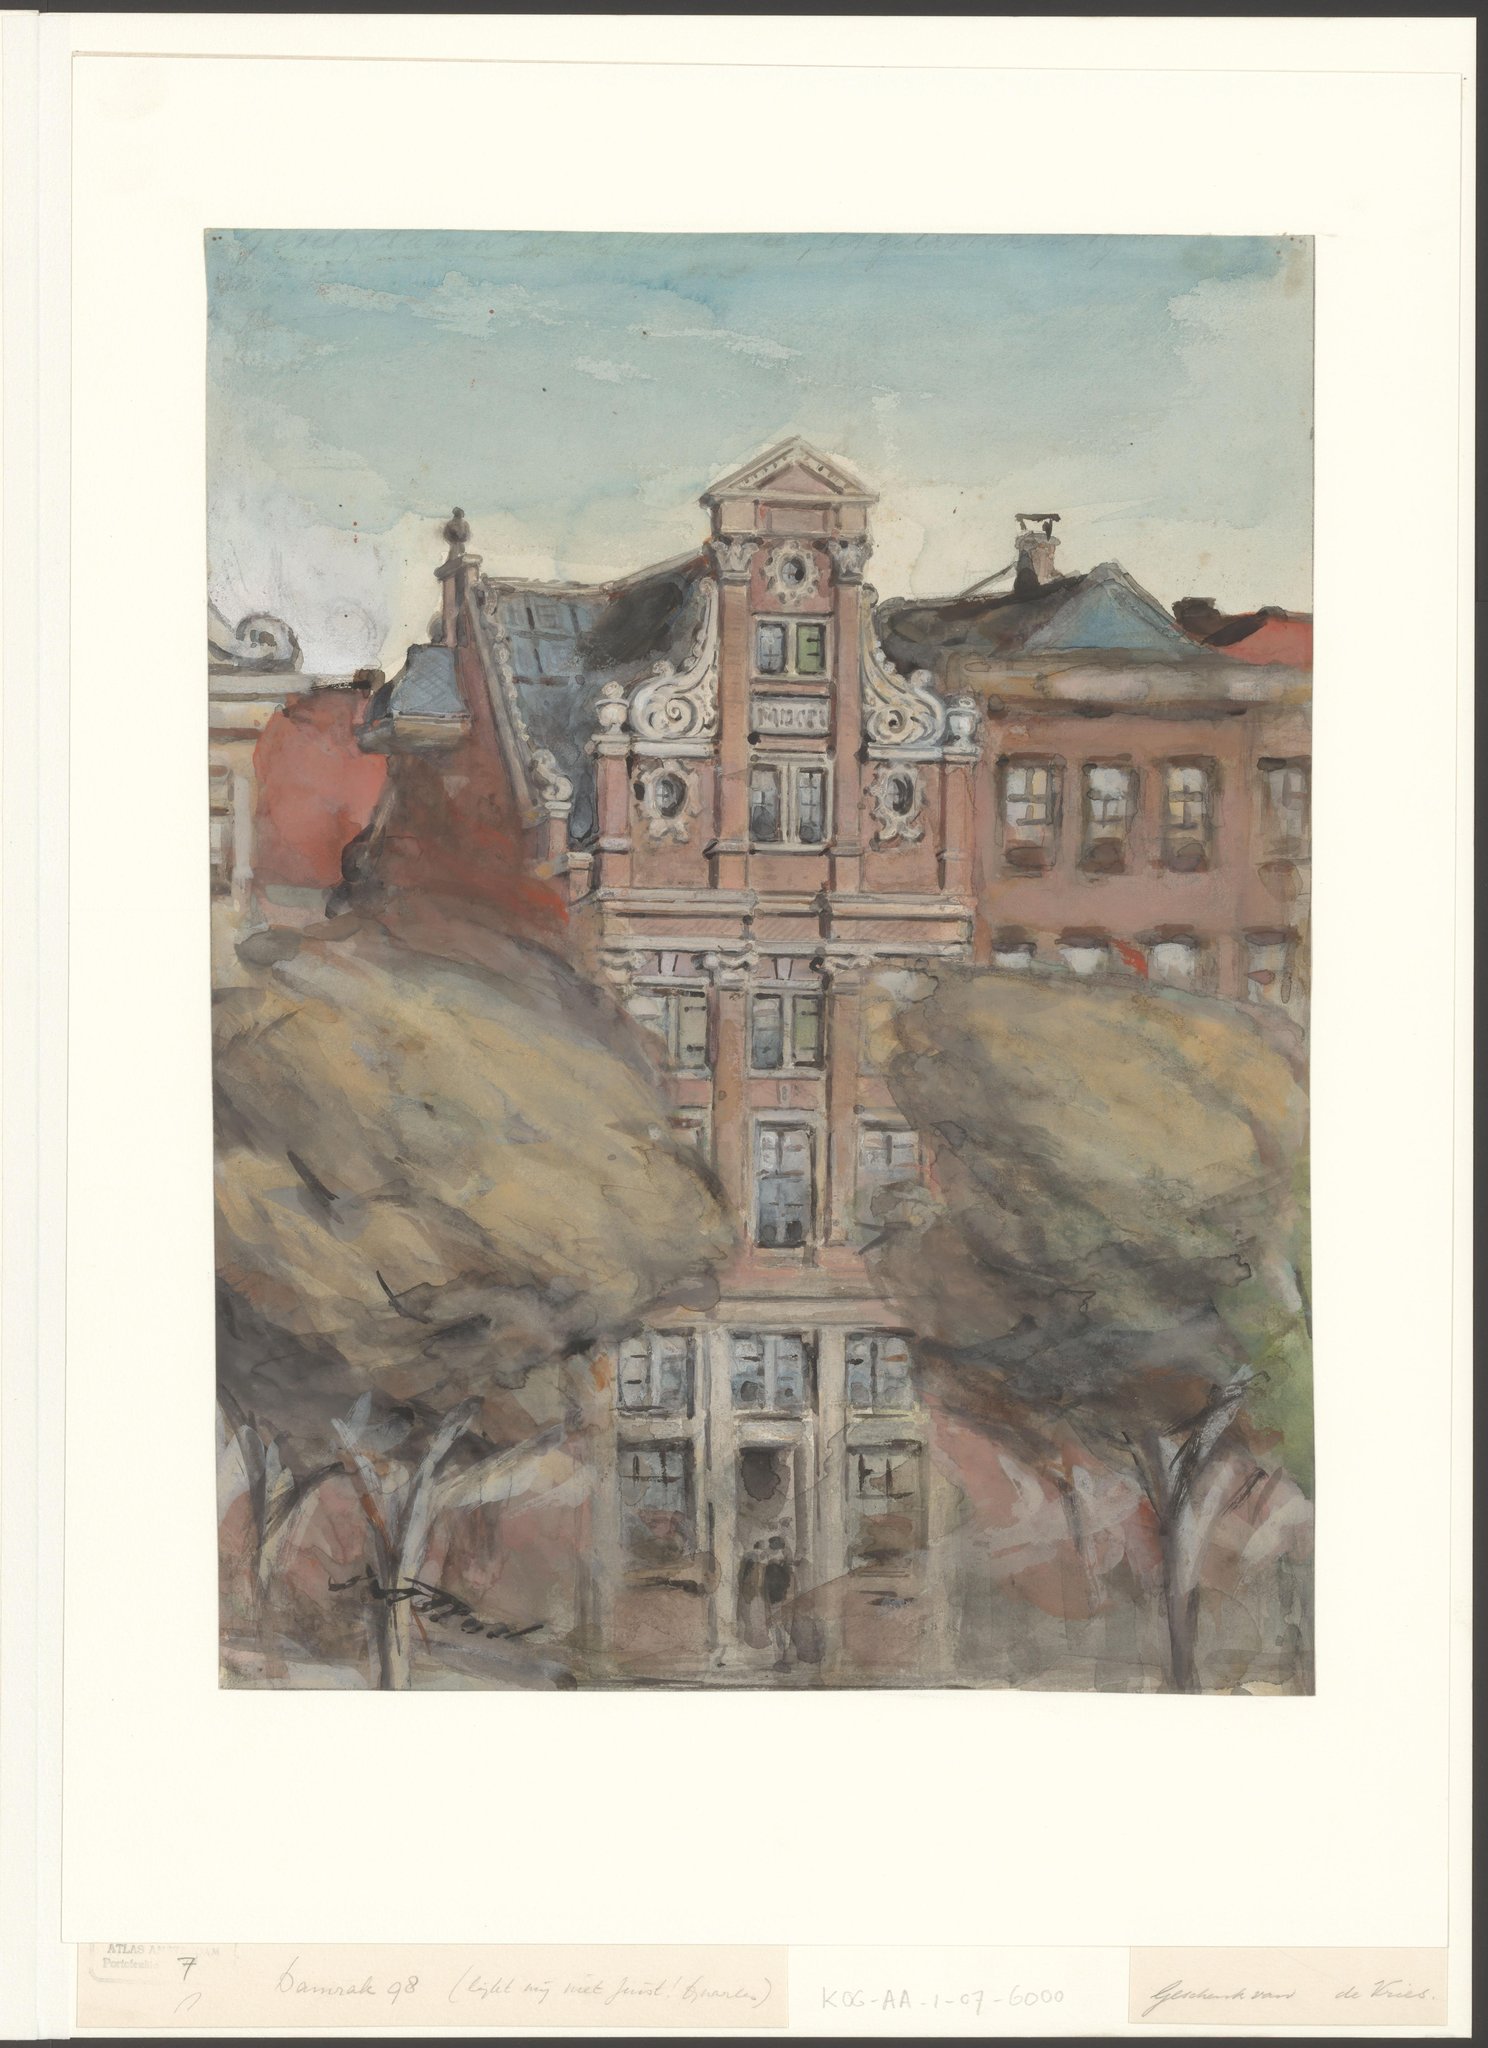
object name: drawing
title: Gezicht op een gevel, mogelijk Damrak 98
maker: johan adolph rust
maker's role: draughtsman, painter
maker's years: 1828-1915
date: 1838-1911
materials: paint, gouache, paper, pencil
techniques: brush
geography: amsterdam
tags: city-view in general; 'veduta', façade (of house or building)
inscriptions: inscription: ‘Port. 7 / A’, inscription: ‘Gevel damrak hoek (...) afgebroken in 1911 / [...] (?)’, inscription: ‘Damrak 98 (lijkt (...) van de Vries.’, collector's mark: ‘7’ Lugt 1641b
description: Onderwerpsrubriek binnen de Atlas Amsterdam: Damrak, Damstraat, Doelensluis, Doelenstraat (Nieuwe), Driehoekstraat, Droogbak, Duvelshoek, Dijkstraat en Korte -.